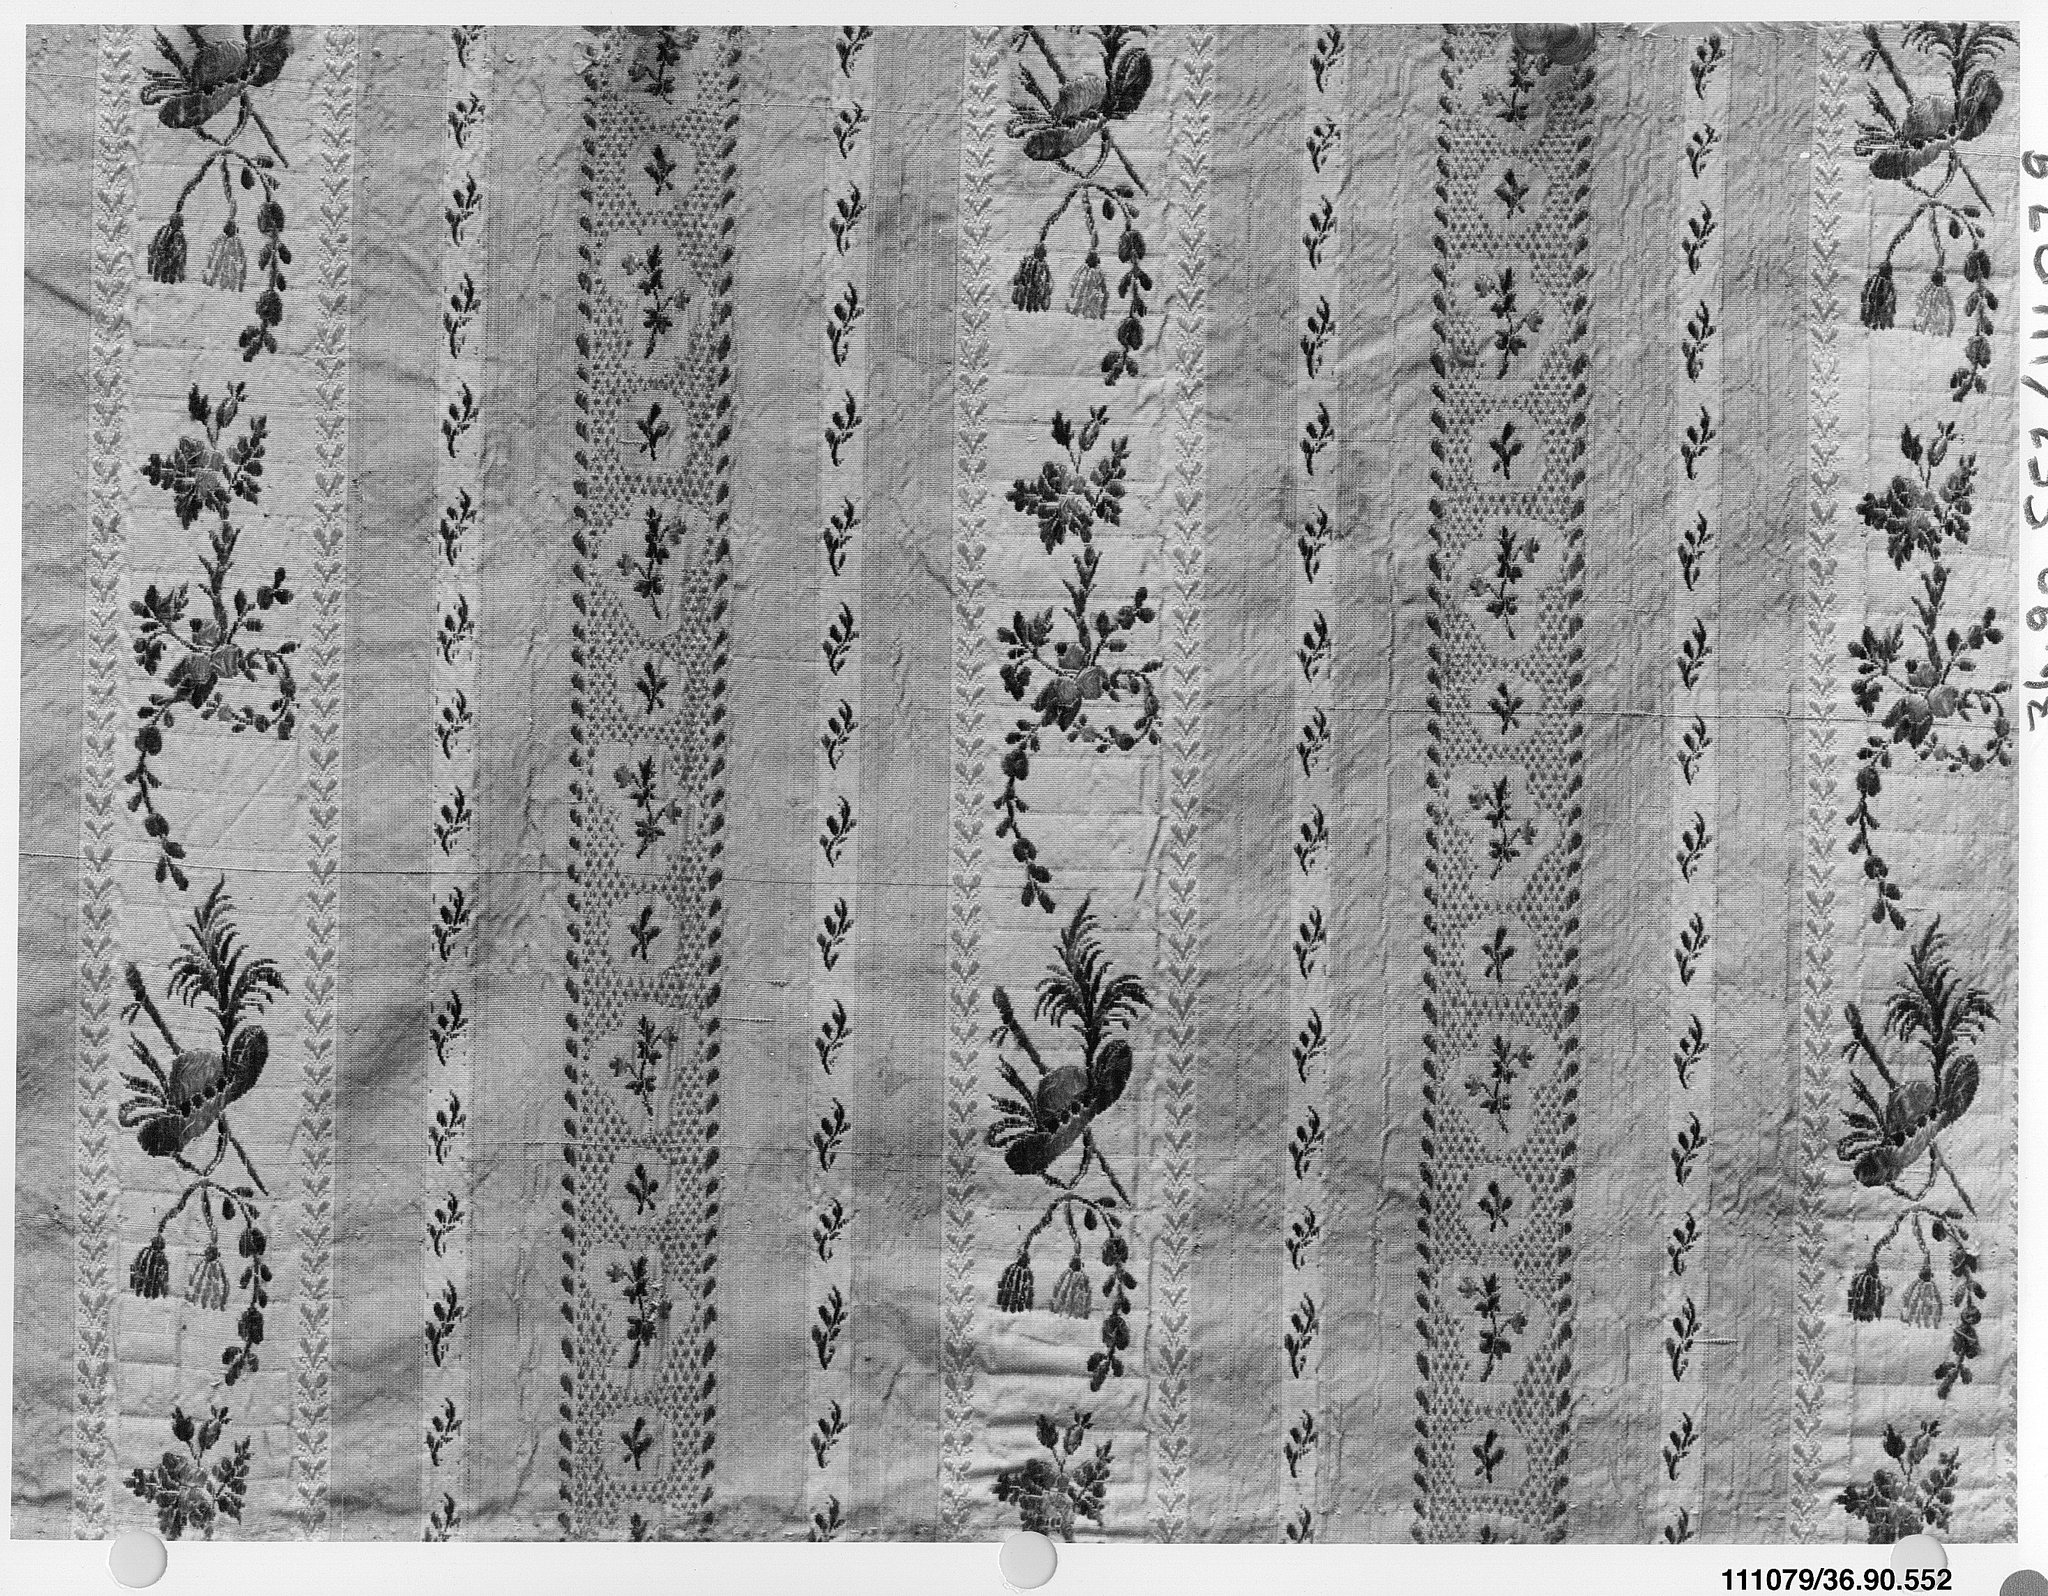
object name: piece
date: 1767-1800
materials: silk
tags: flowers